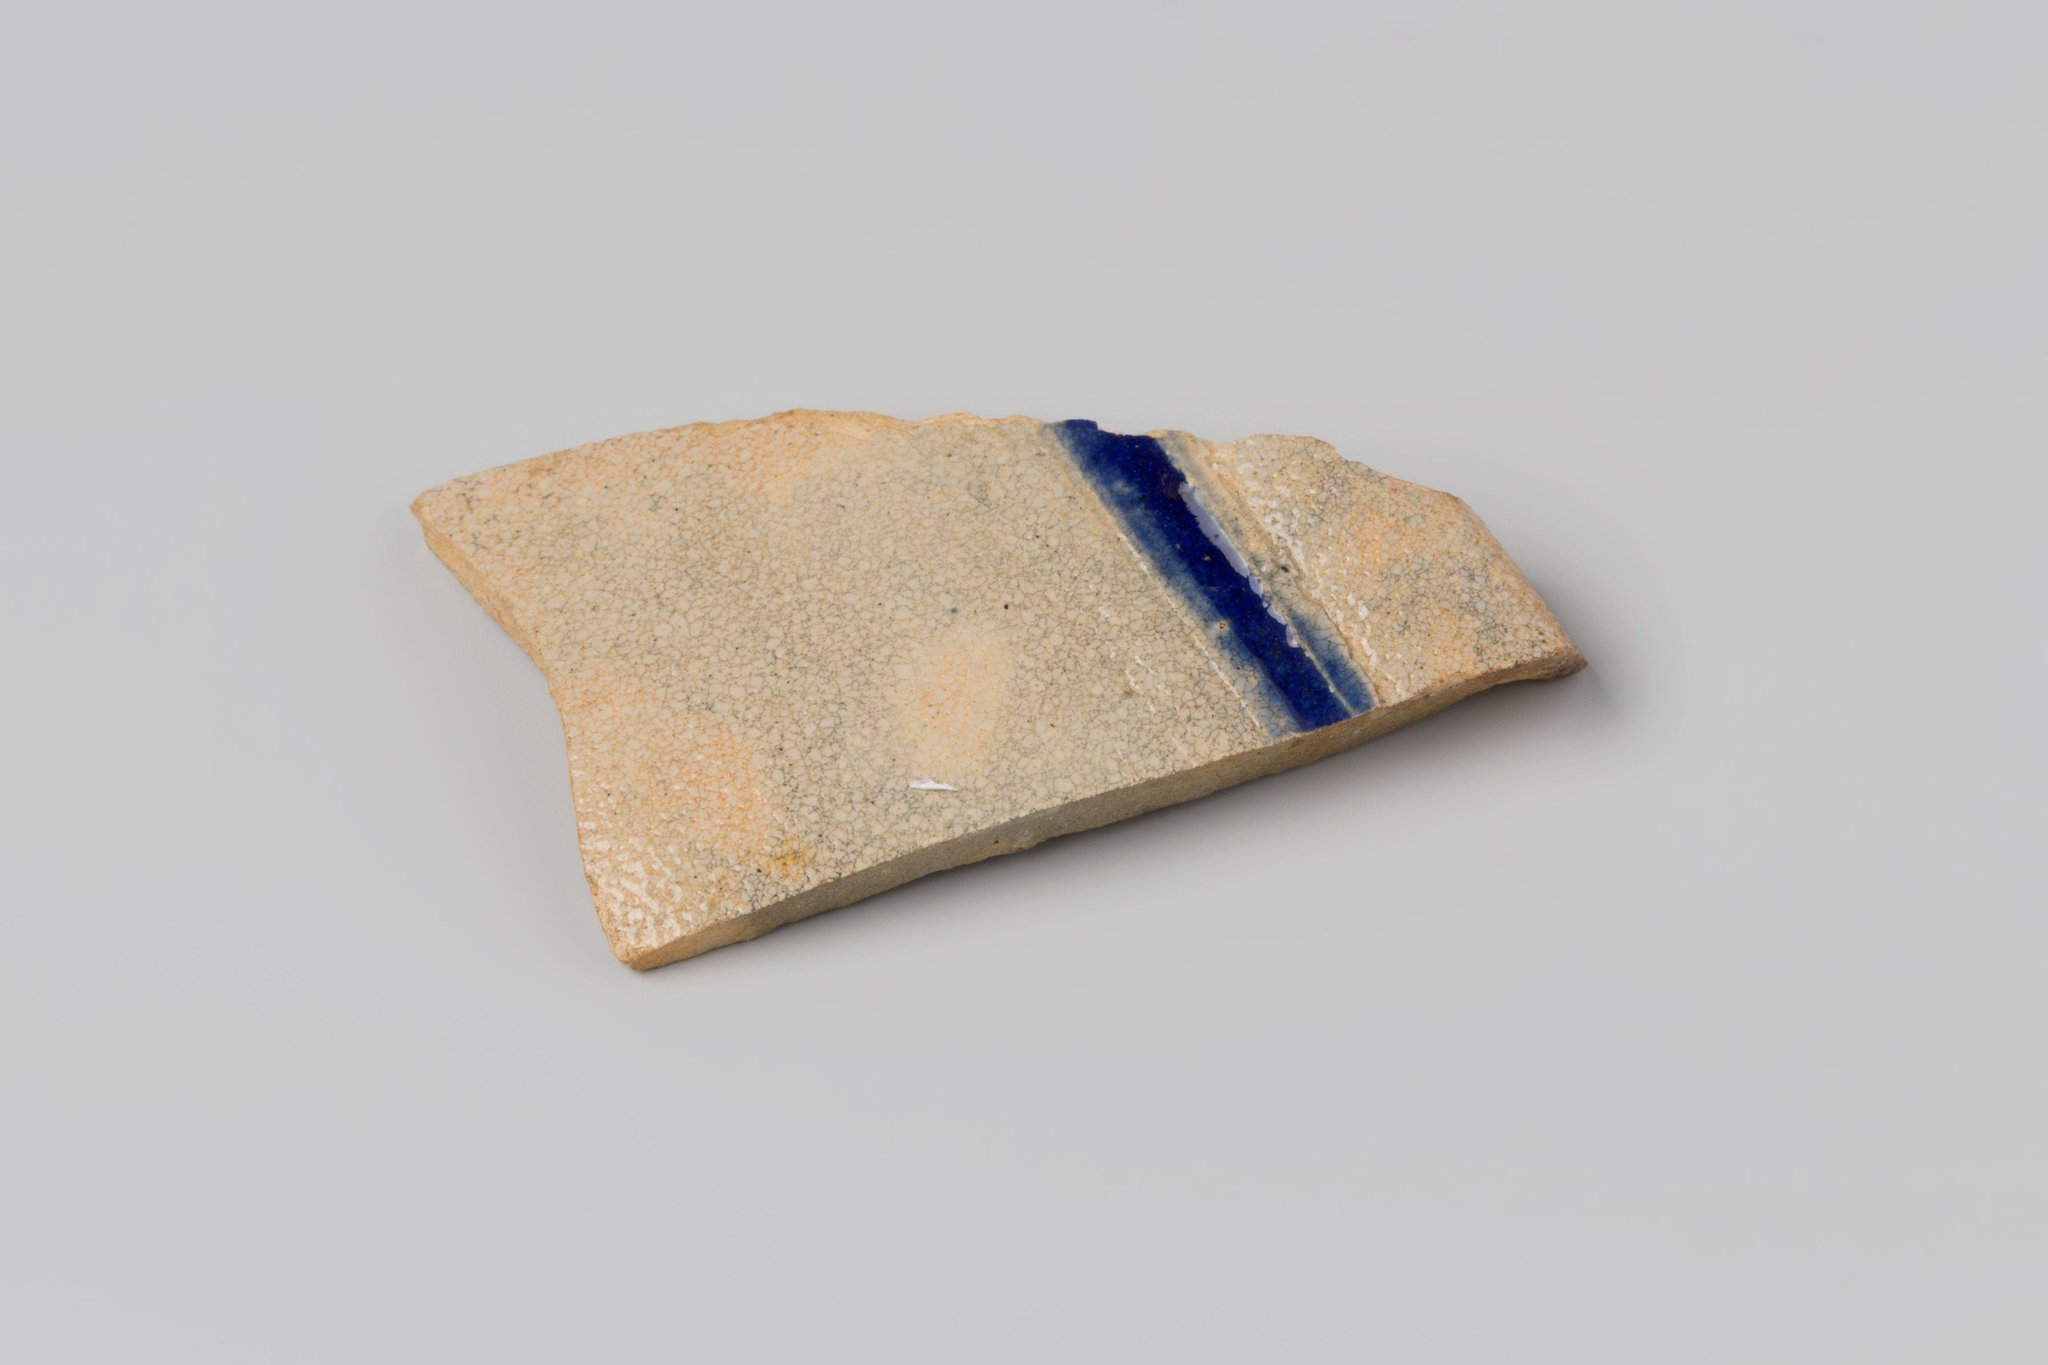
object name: pot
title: Scherf van een pot uit het wrak van de Oost-Indiëvaarder Hollandia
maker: Anonymous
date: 1700-1743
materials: stoneware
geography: westerwald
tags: verenigde oostindische compagnie, hollandia (schip), annet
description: Stoneware, Rhenish, Westerwald, pot; of base and body, sim. NG 1980-27H2624r.